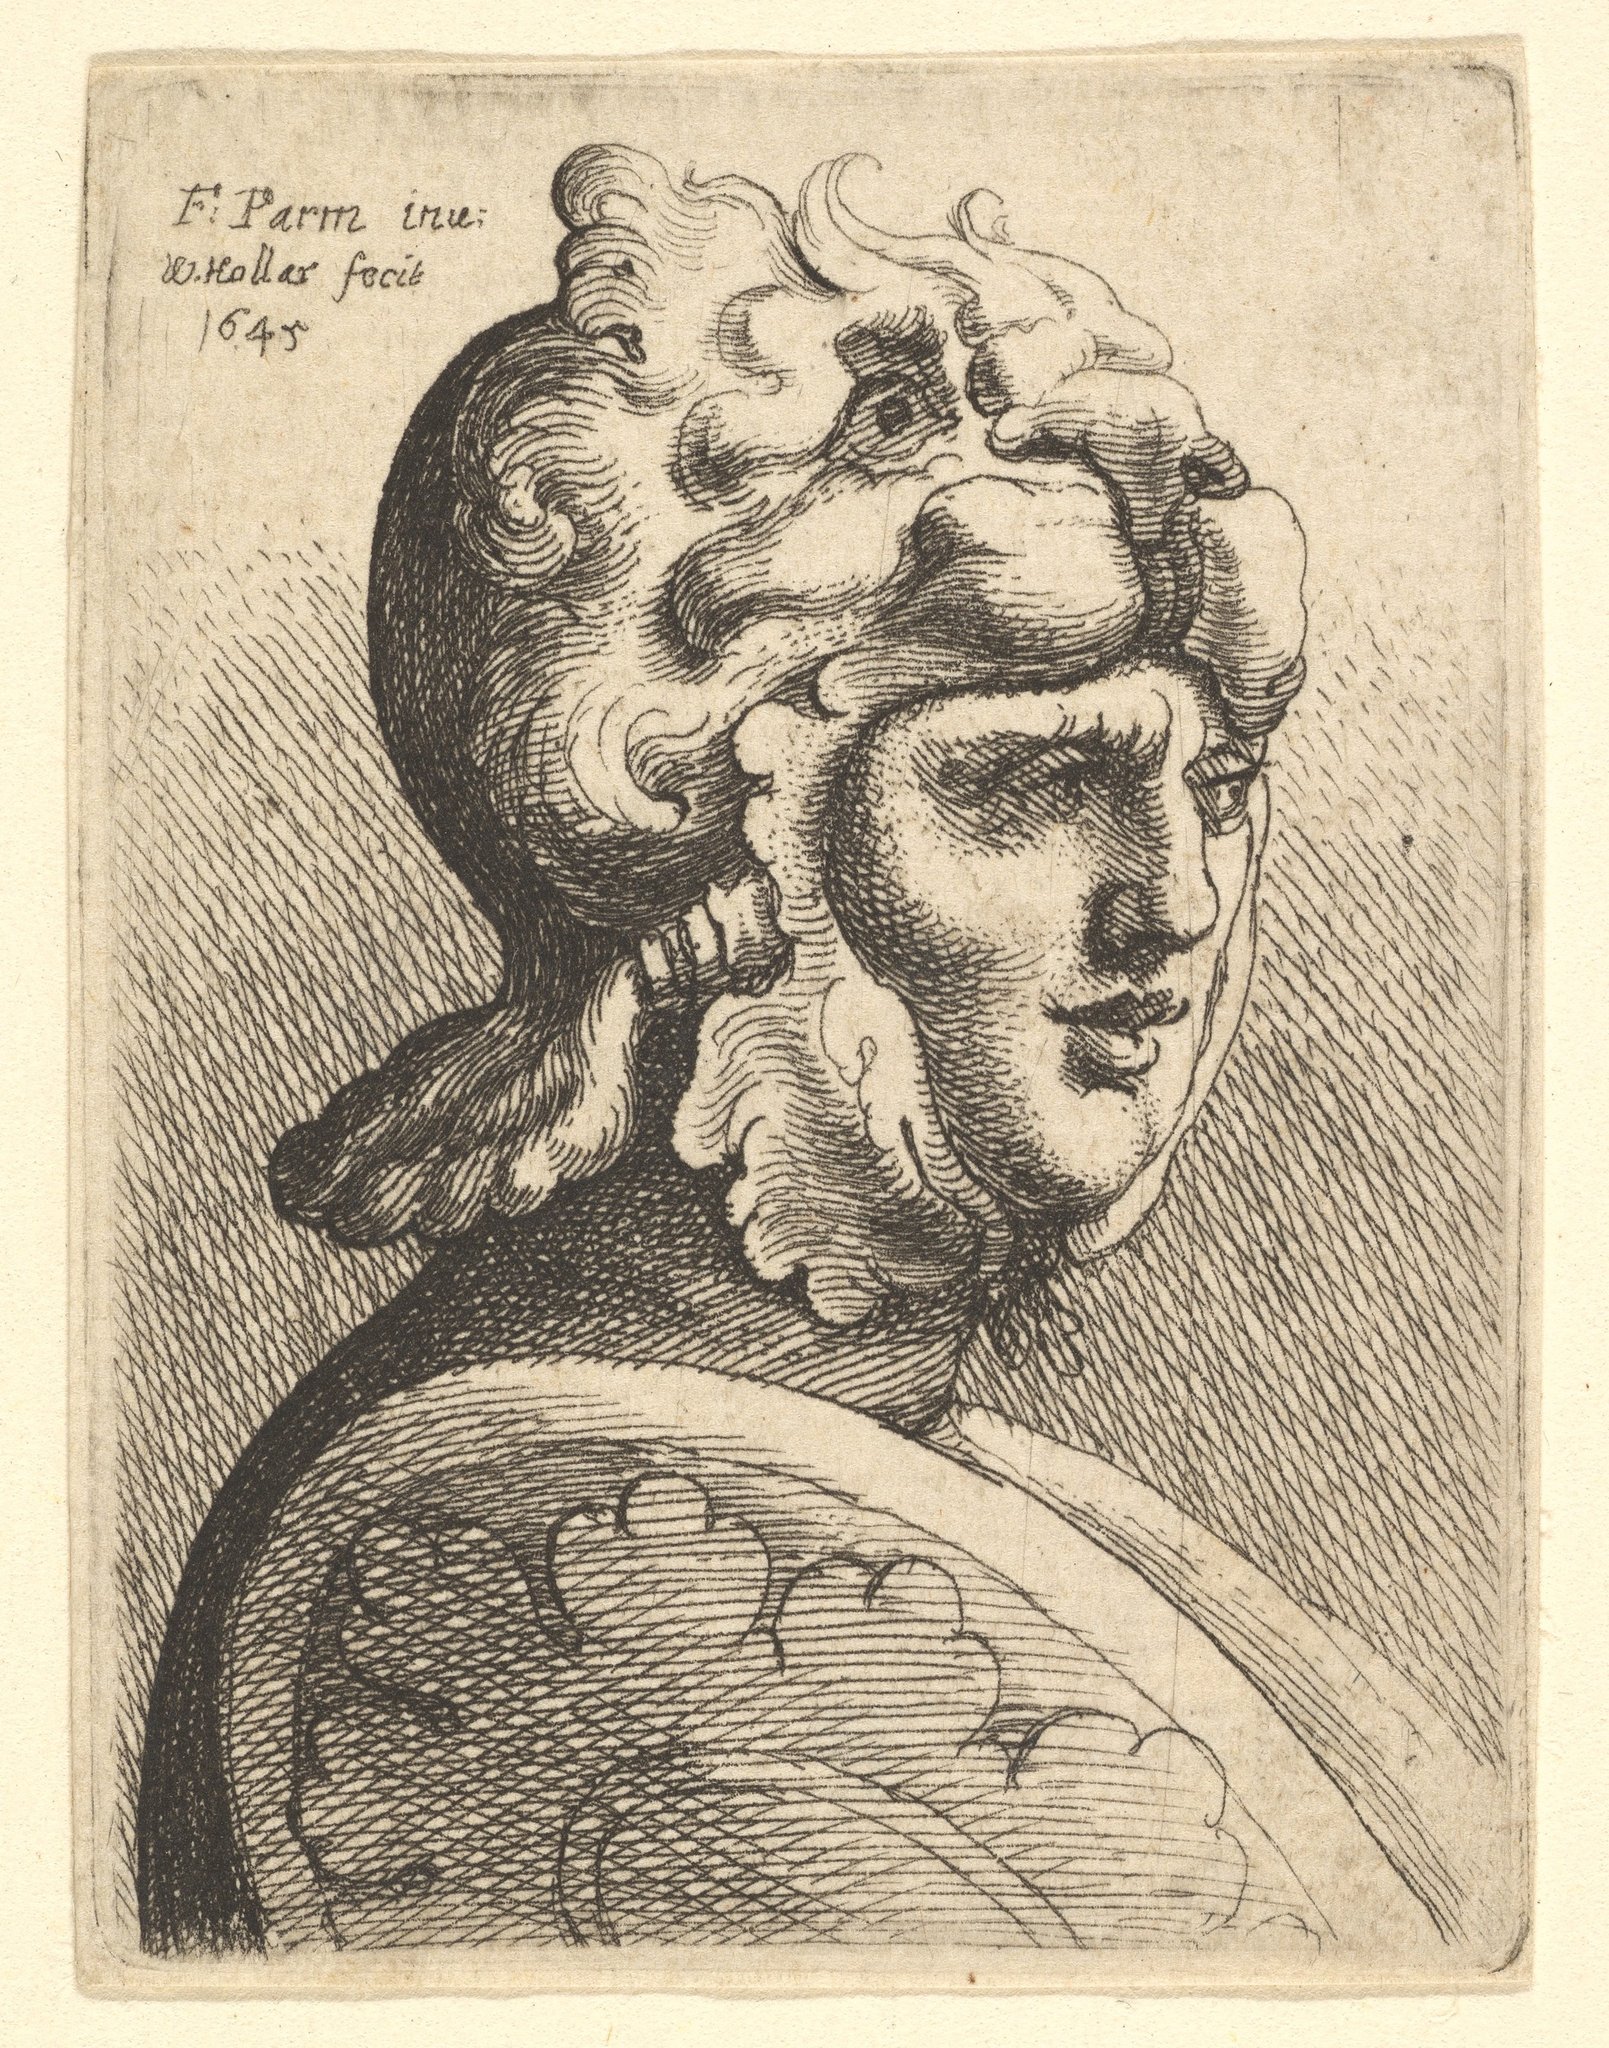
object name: print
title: Helmeted Head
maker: wenceslaus hollar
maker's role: artist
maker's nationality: bohemian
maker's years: 1607-1677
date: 1645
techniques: etching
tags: helmets,warriors